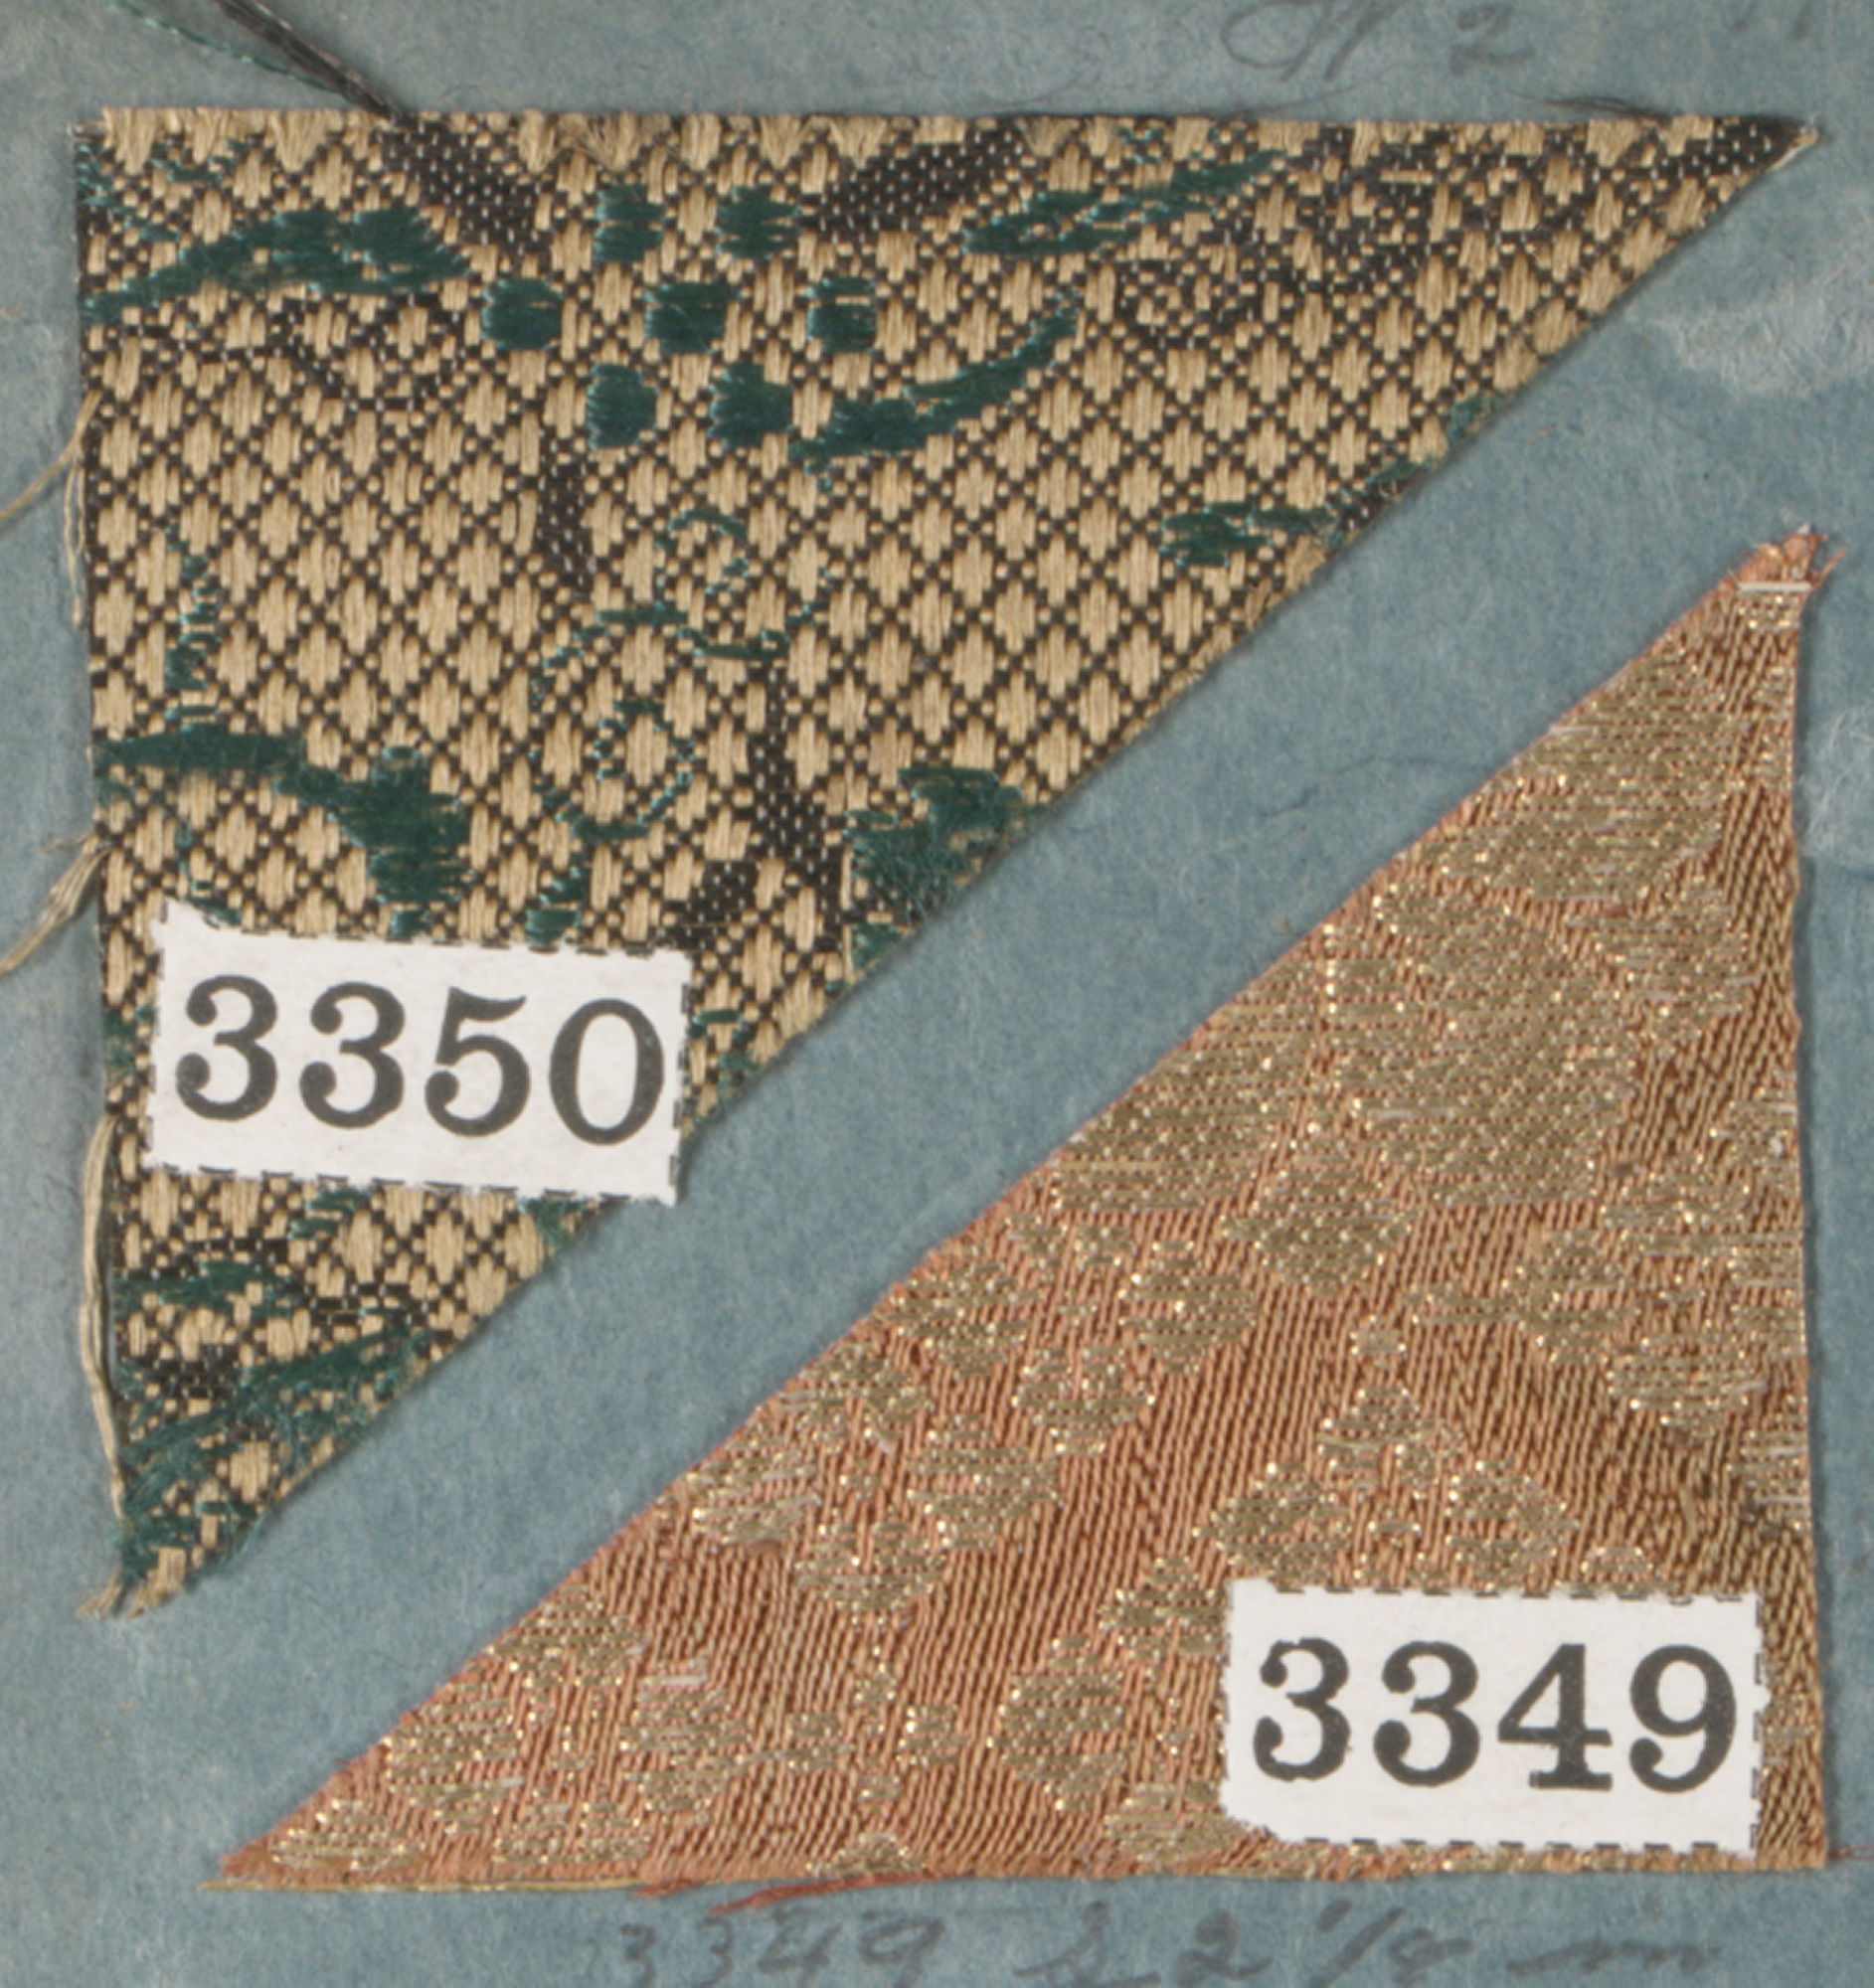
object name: textile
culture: japanese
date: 1801-1900